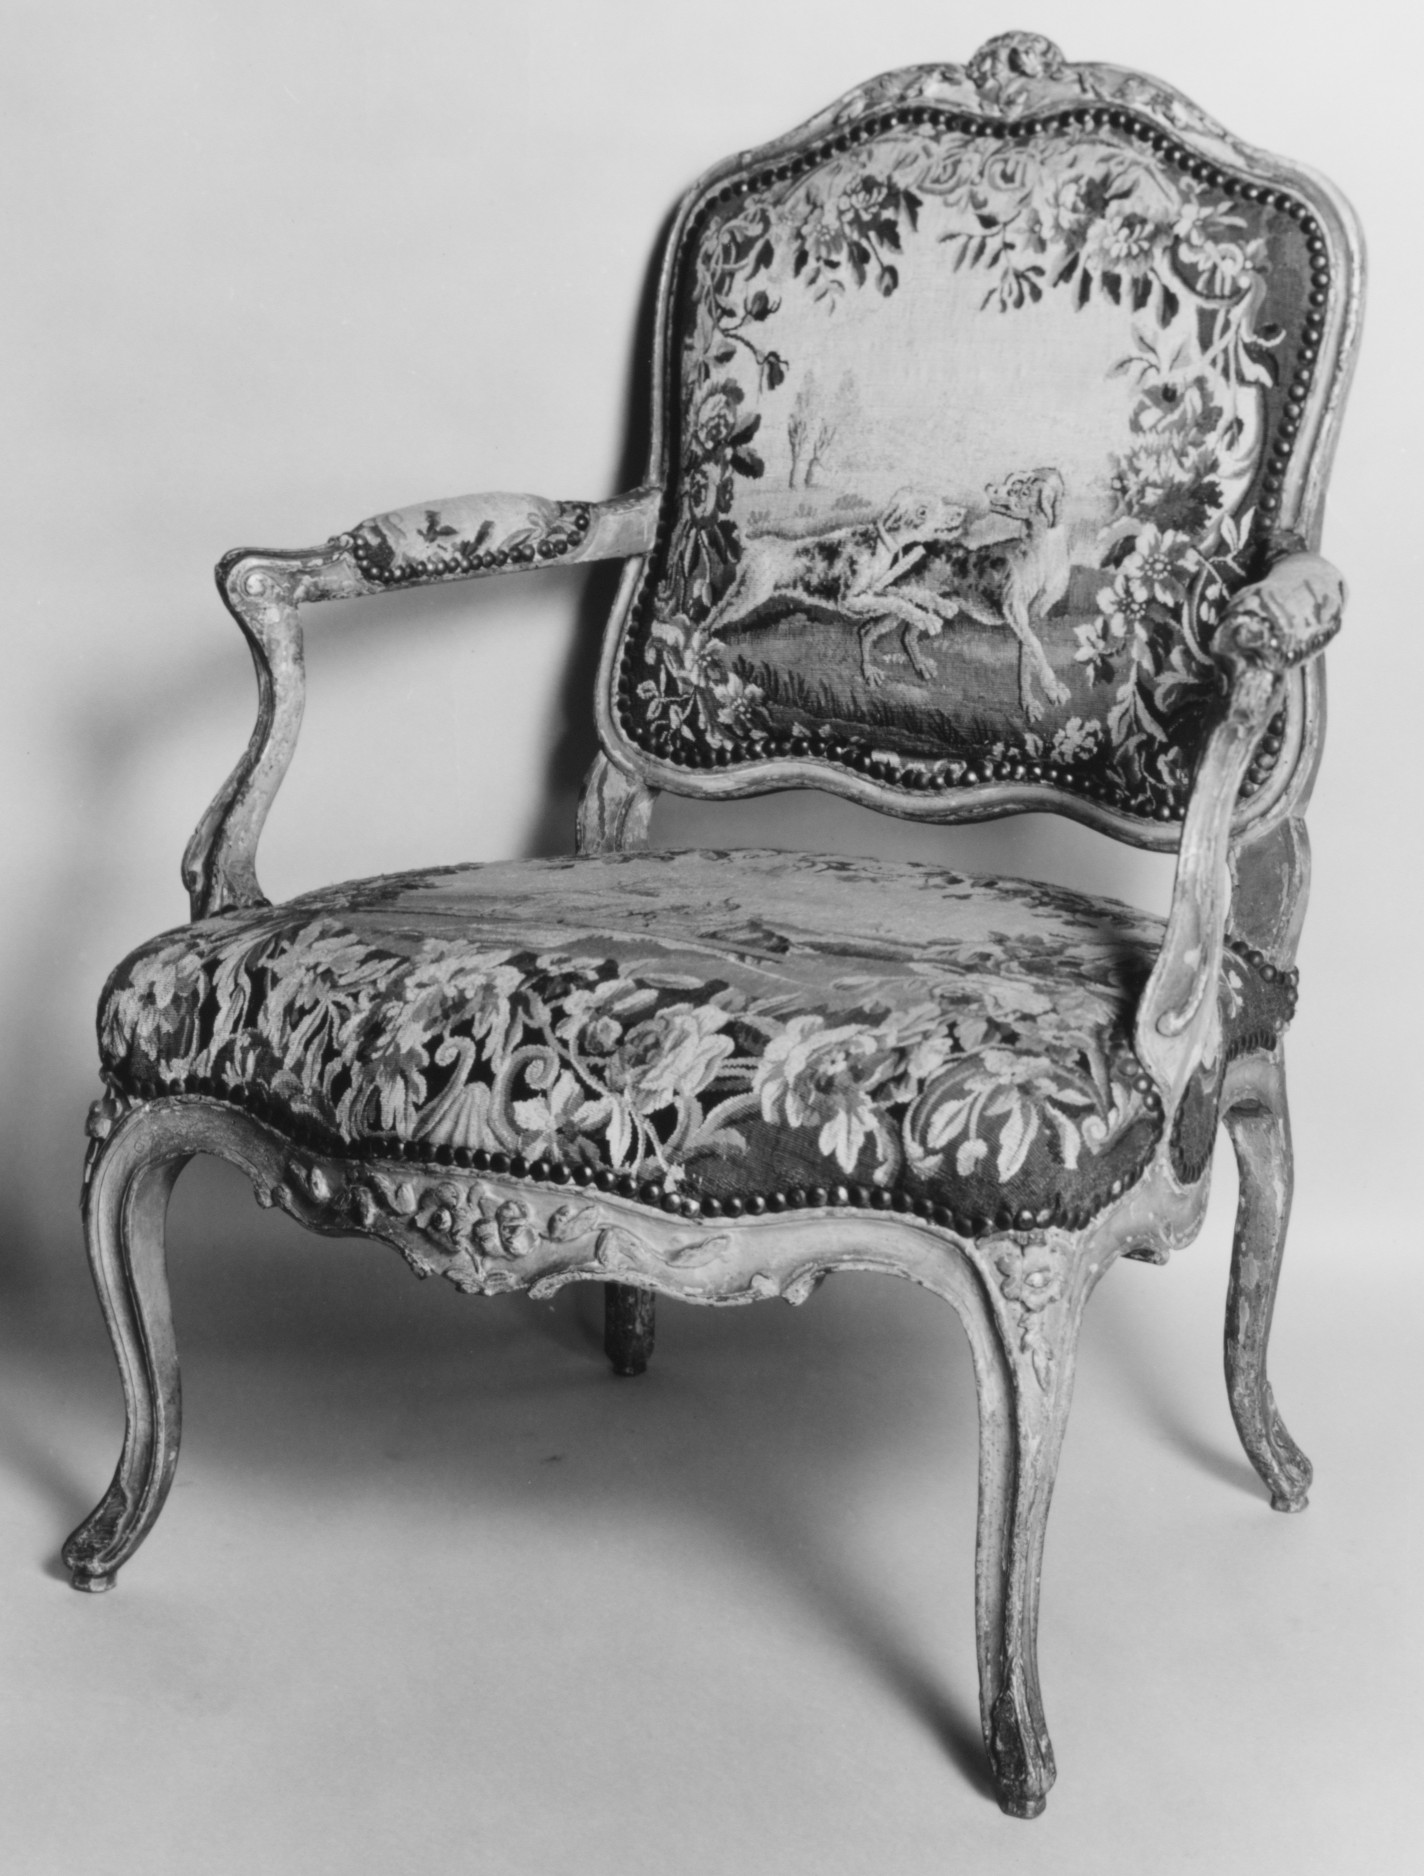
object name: armchair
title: Armchair (part of a set of nine)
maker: aubusson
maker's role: factory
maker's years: 1665-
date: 1734-1766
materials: wood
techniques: carving, painting, tapestry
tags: dogs,flowers